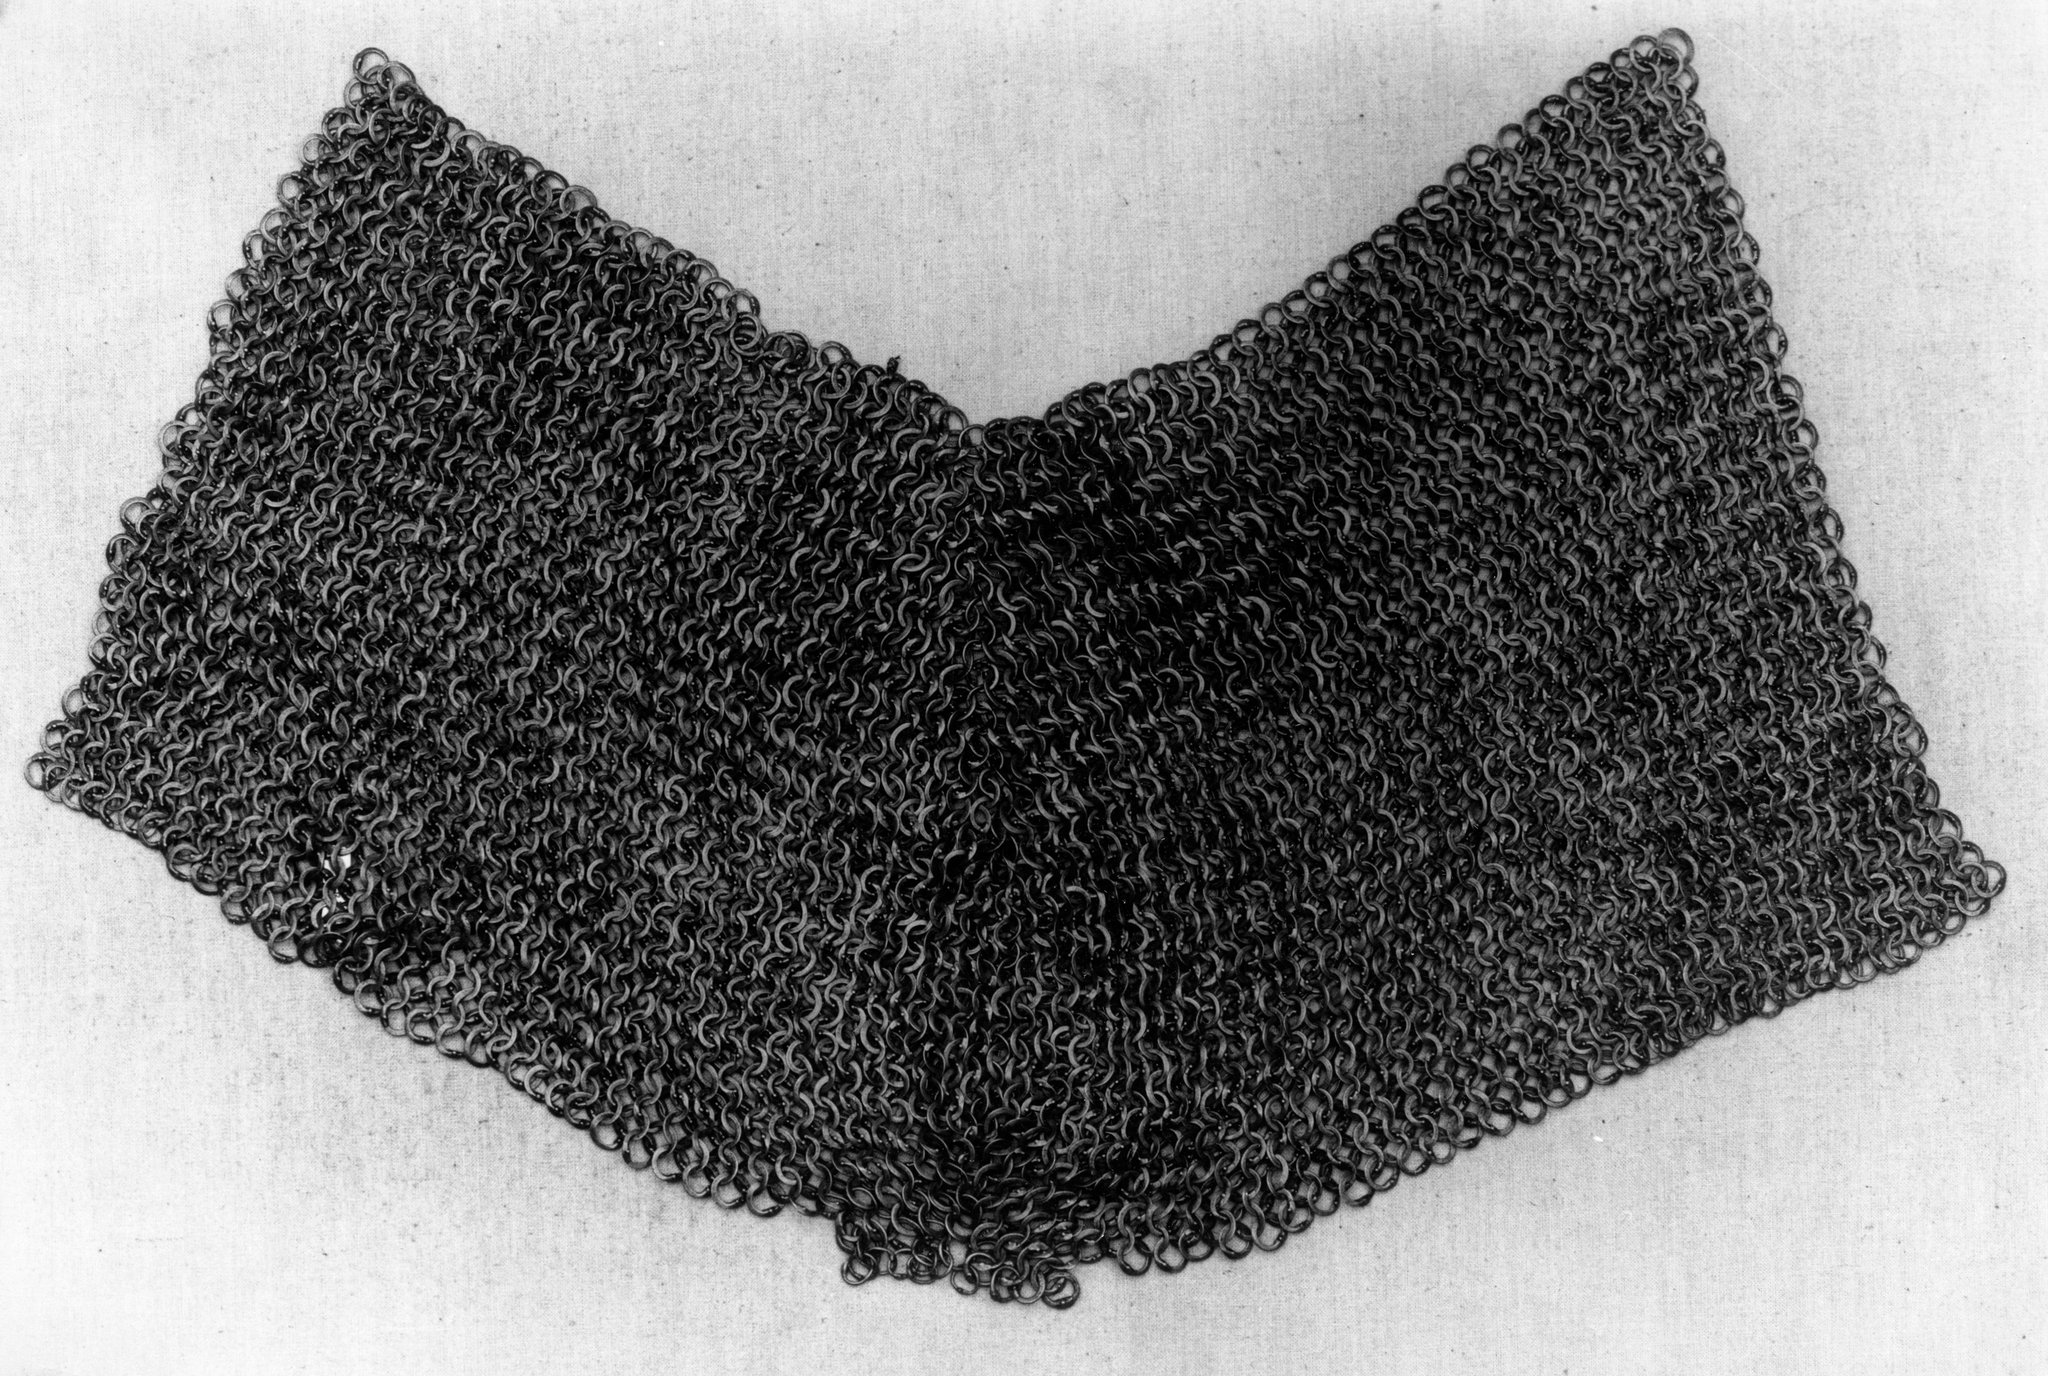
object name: brayette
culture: german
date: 1501-1600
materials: steel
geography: germany